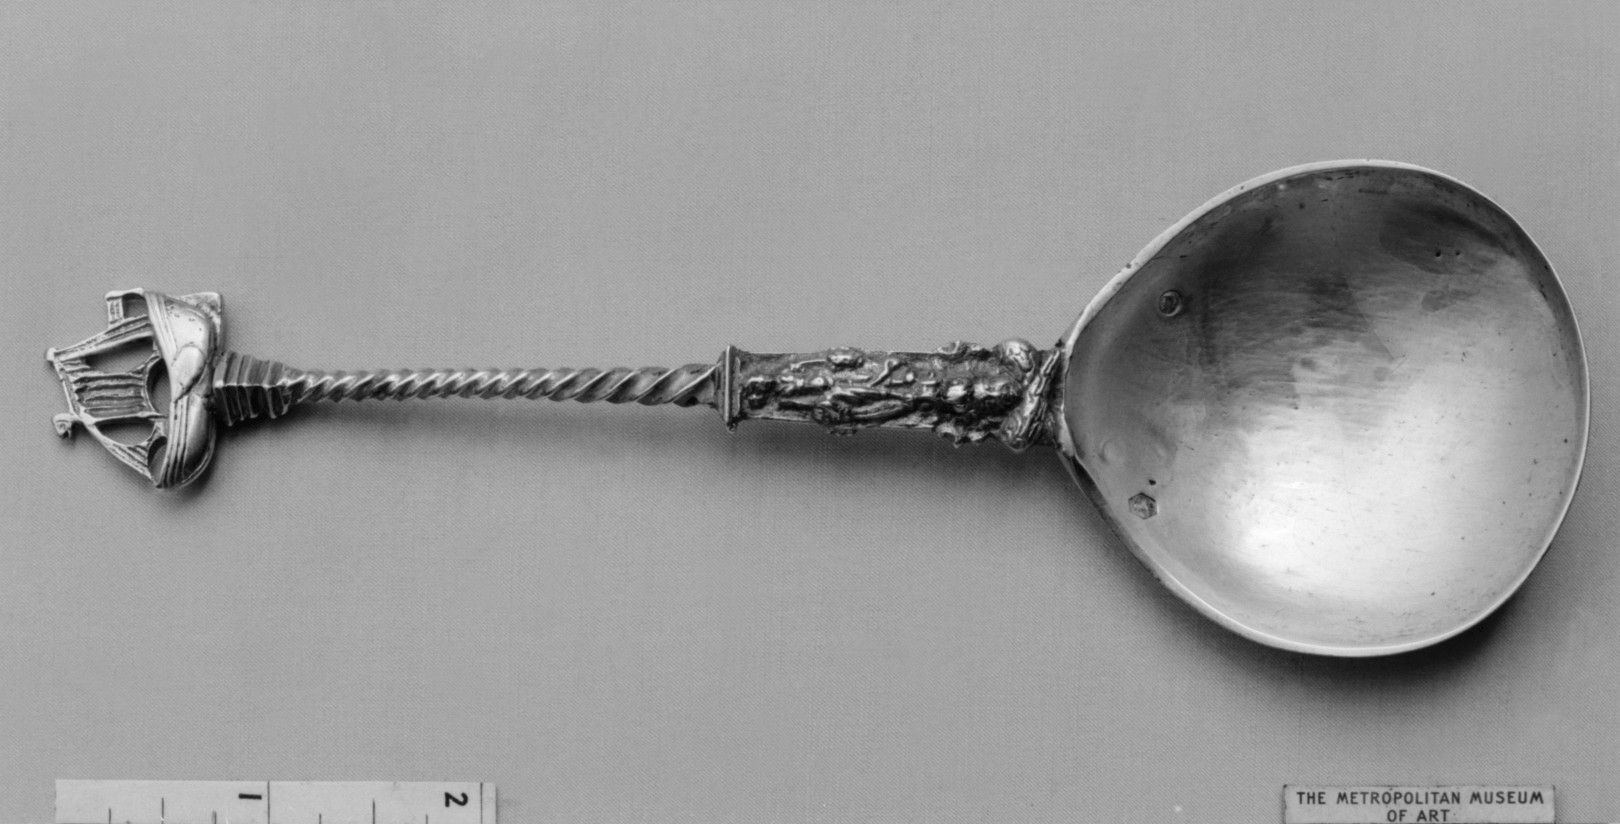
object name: spoon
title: Figure-top spoon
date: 1827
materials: silver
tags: human figures,ships